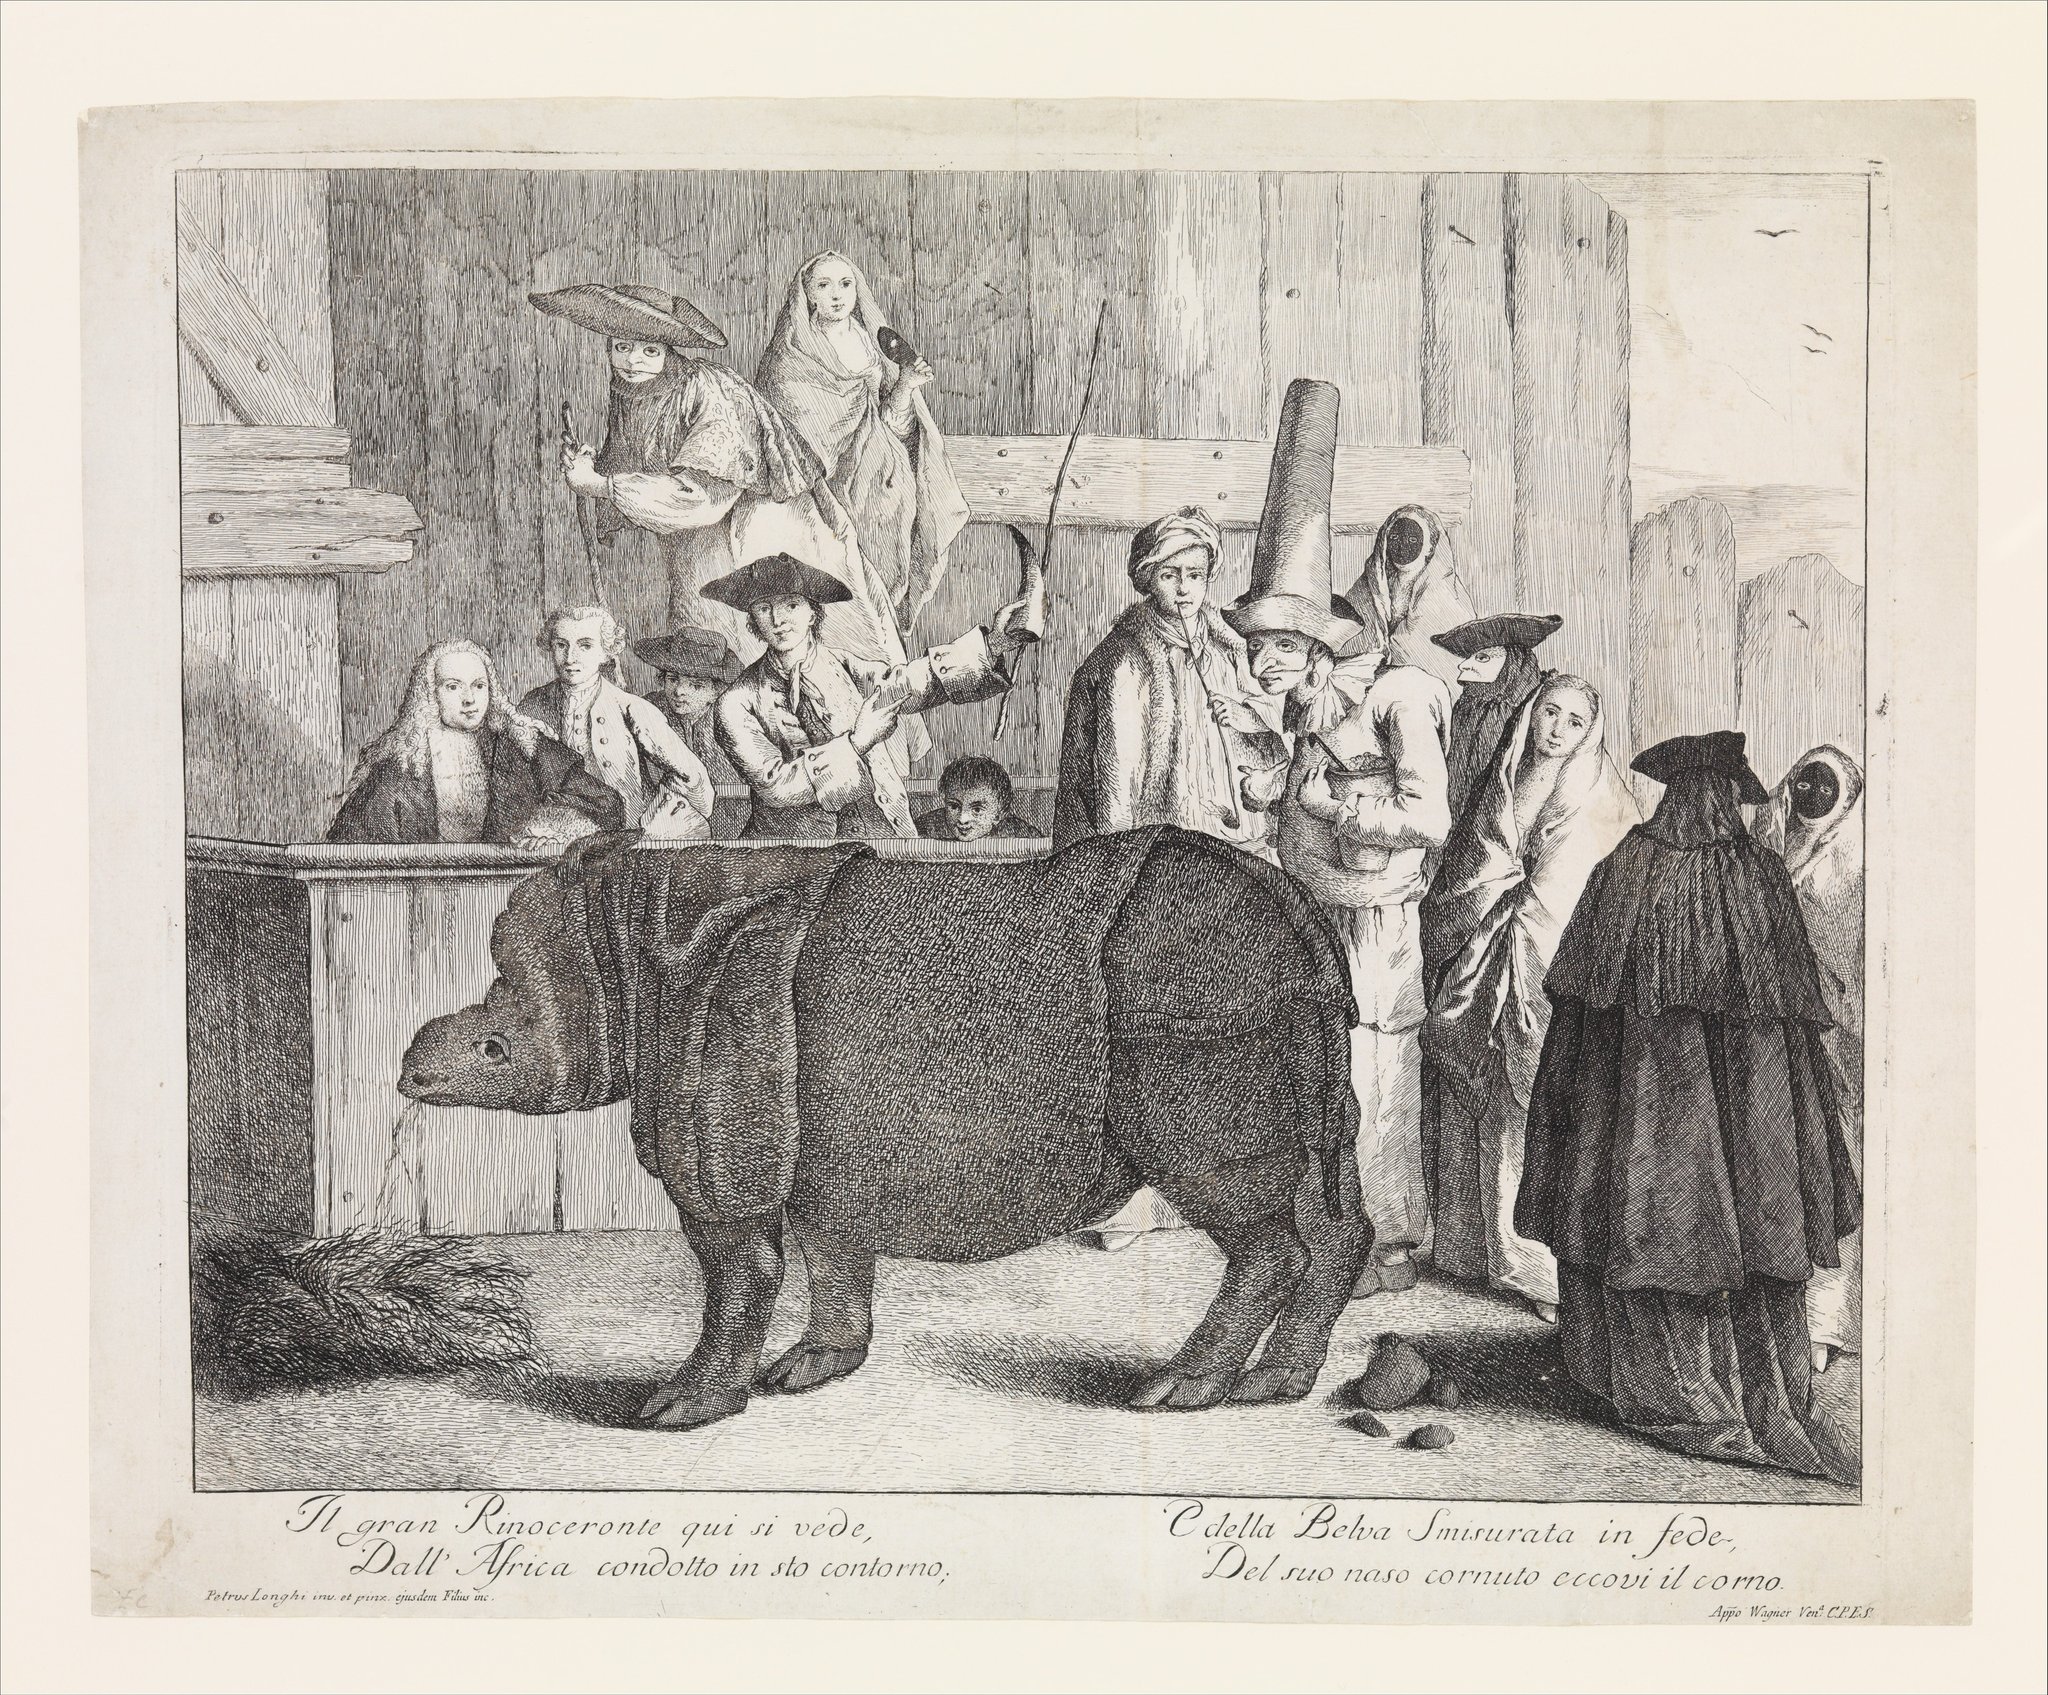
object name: print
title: The Rhinoceros, Clara, in the foreground, her keeper holding her horn and a whip behind her at center with various other spectators in Carnival masks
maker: alessandro longhi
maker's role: artist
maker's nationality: italian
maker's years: 1733-1813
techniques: etching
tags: animals,women,spectators